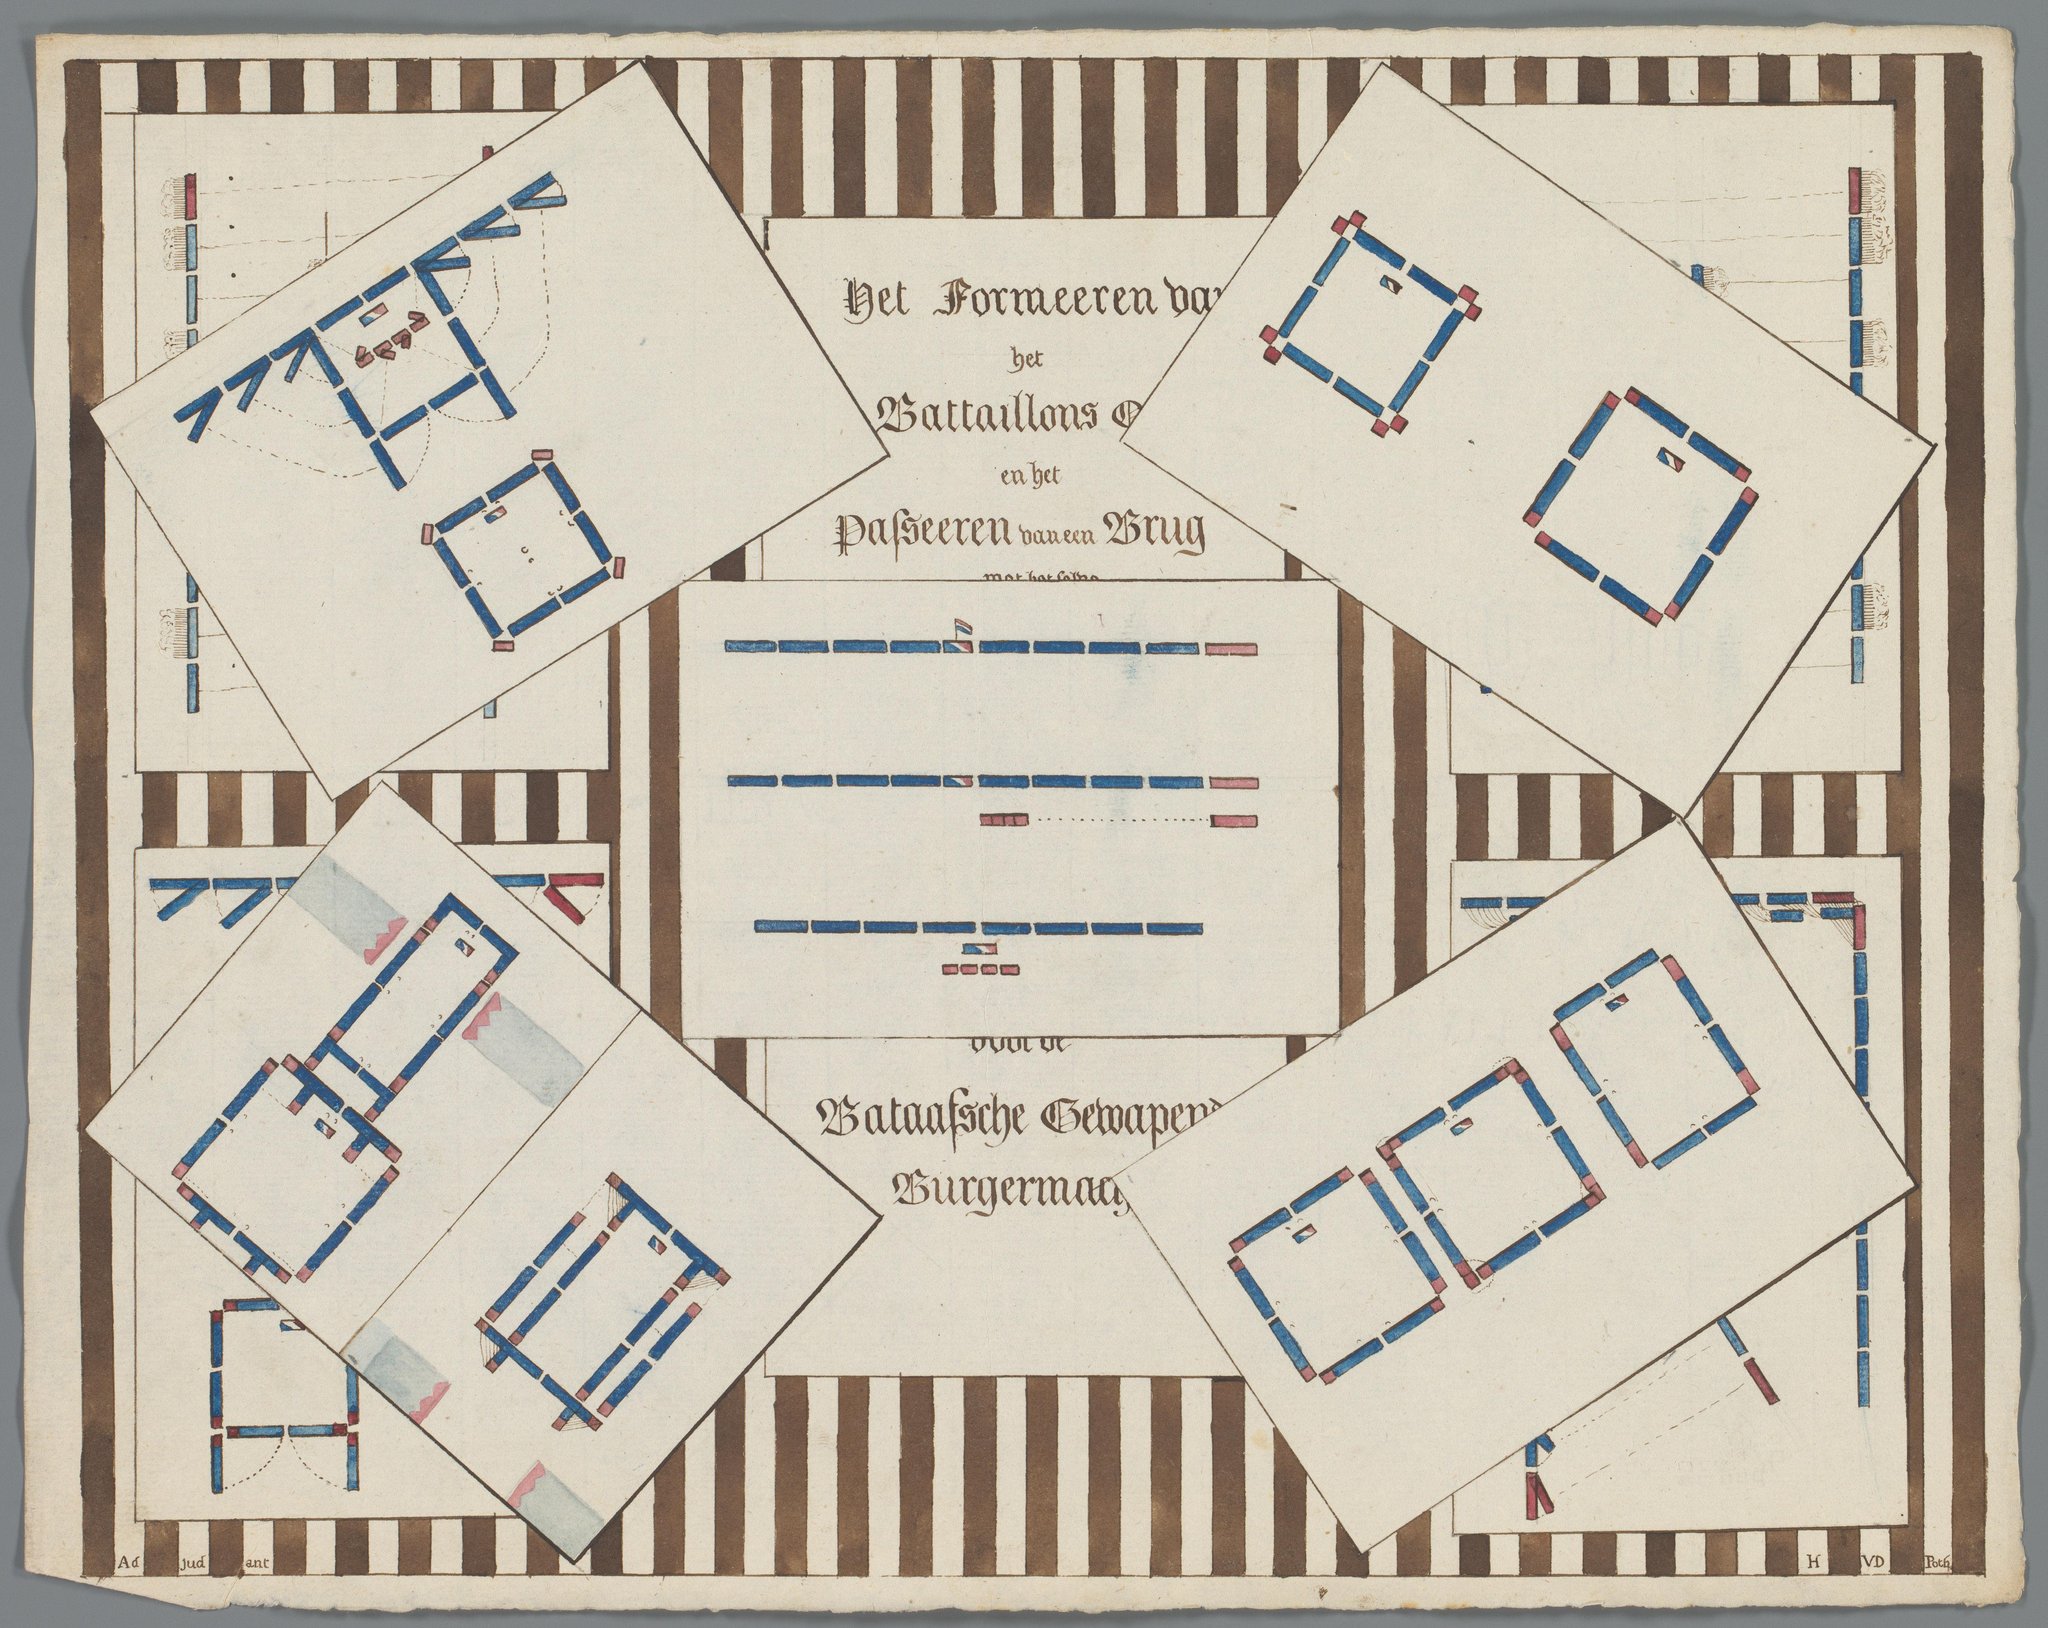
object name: trompe l'oeil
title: Boerenbedrieger met bladen met manoeuvres, ca. 1798-1803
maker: hendrik van der poth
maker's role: draughtsman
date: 1798-1803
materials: paper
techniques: writing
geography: netherlands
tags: 'trompe l'oeil', manoeuvre ~ military training, delft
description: Boerenbedrieger of trompe-l'oeil bestaande uit tien bladen papier met plattegronden van manoeuvres van de Bataafsche Gewapende Burgermacht te Delft, ca. 1798-1803.